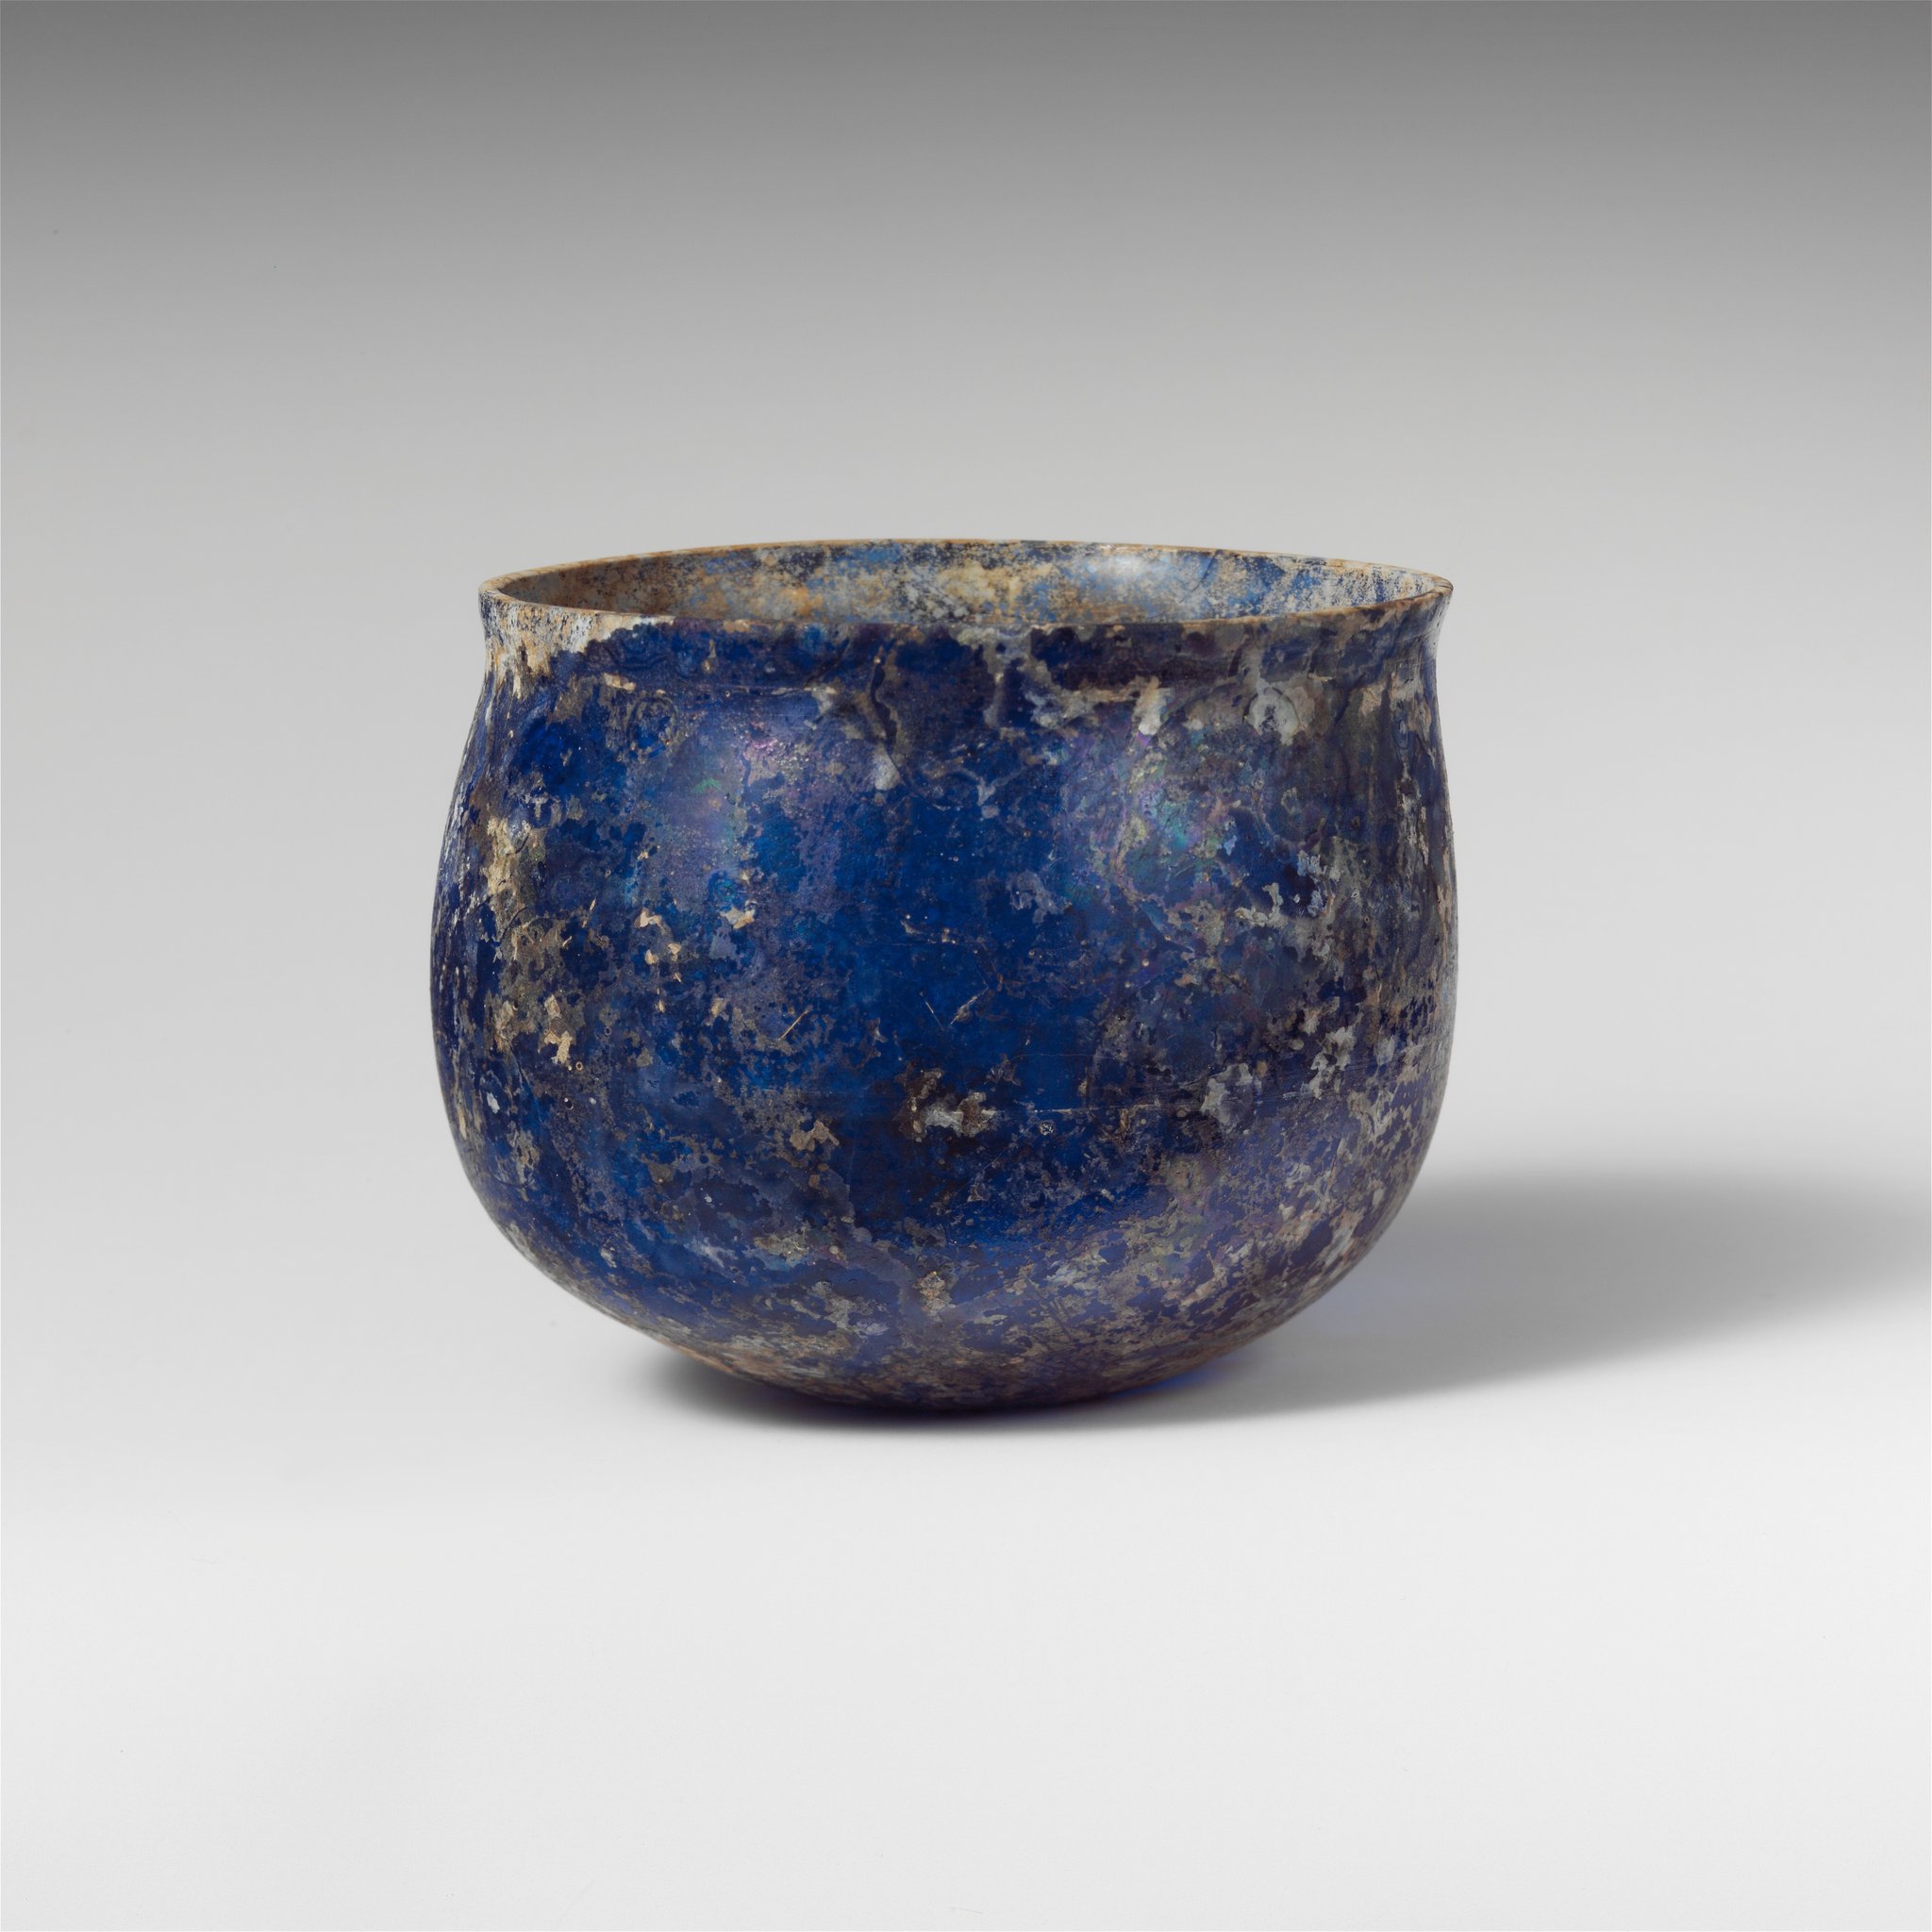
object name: cup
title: Glass cup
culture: roman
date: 1-100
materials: glass